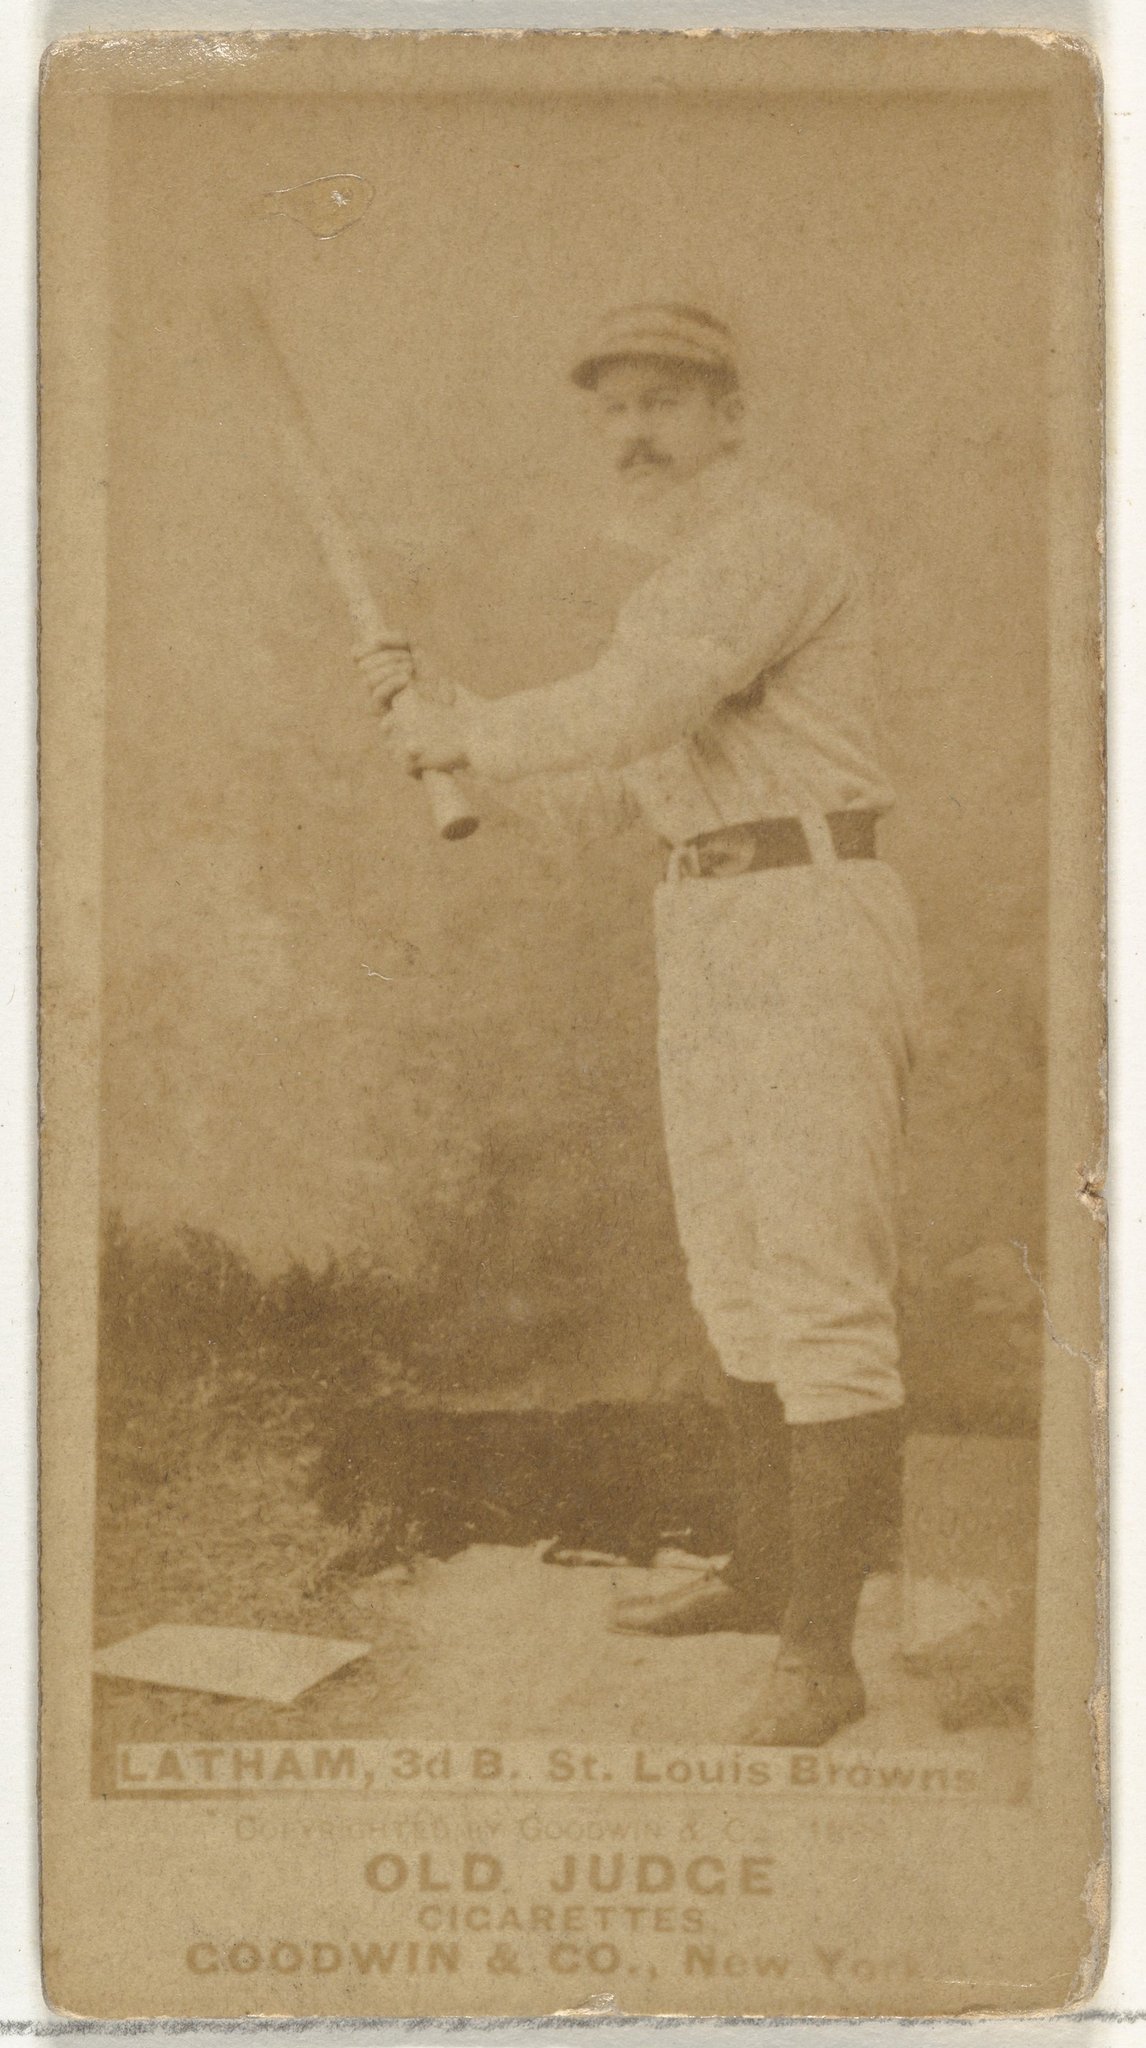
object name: baseball card, photograph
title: Arlie Latham, 3rd Base, St. Louis Browns, from the Old Judge series (N172) for Old Judge Cigarettes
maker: goodwin & company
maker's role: publisher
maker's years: 1850-1950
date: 1887-1889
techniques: albumen silver print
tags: men,portraits,baseball,athletes